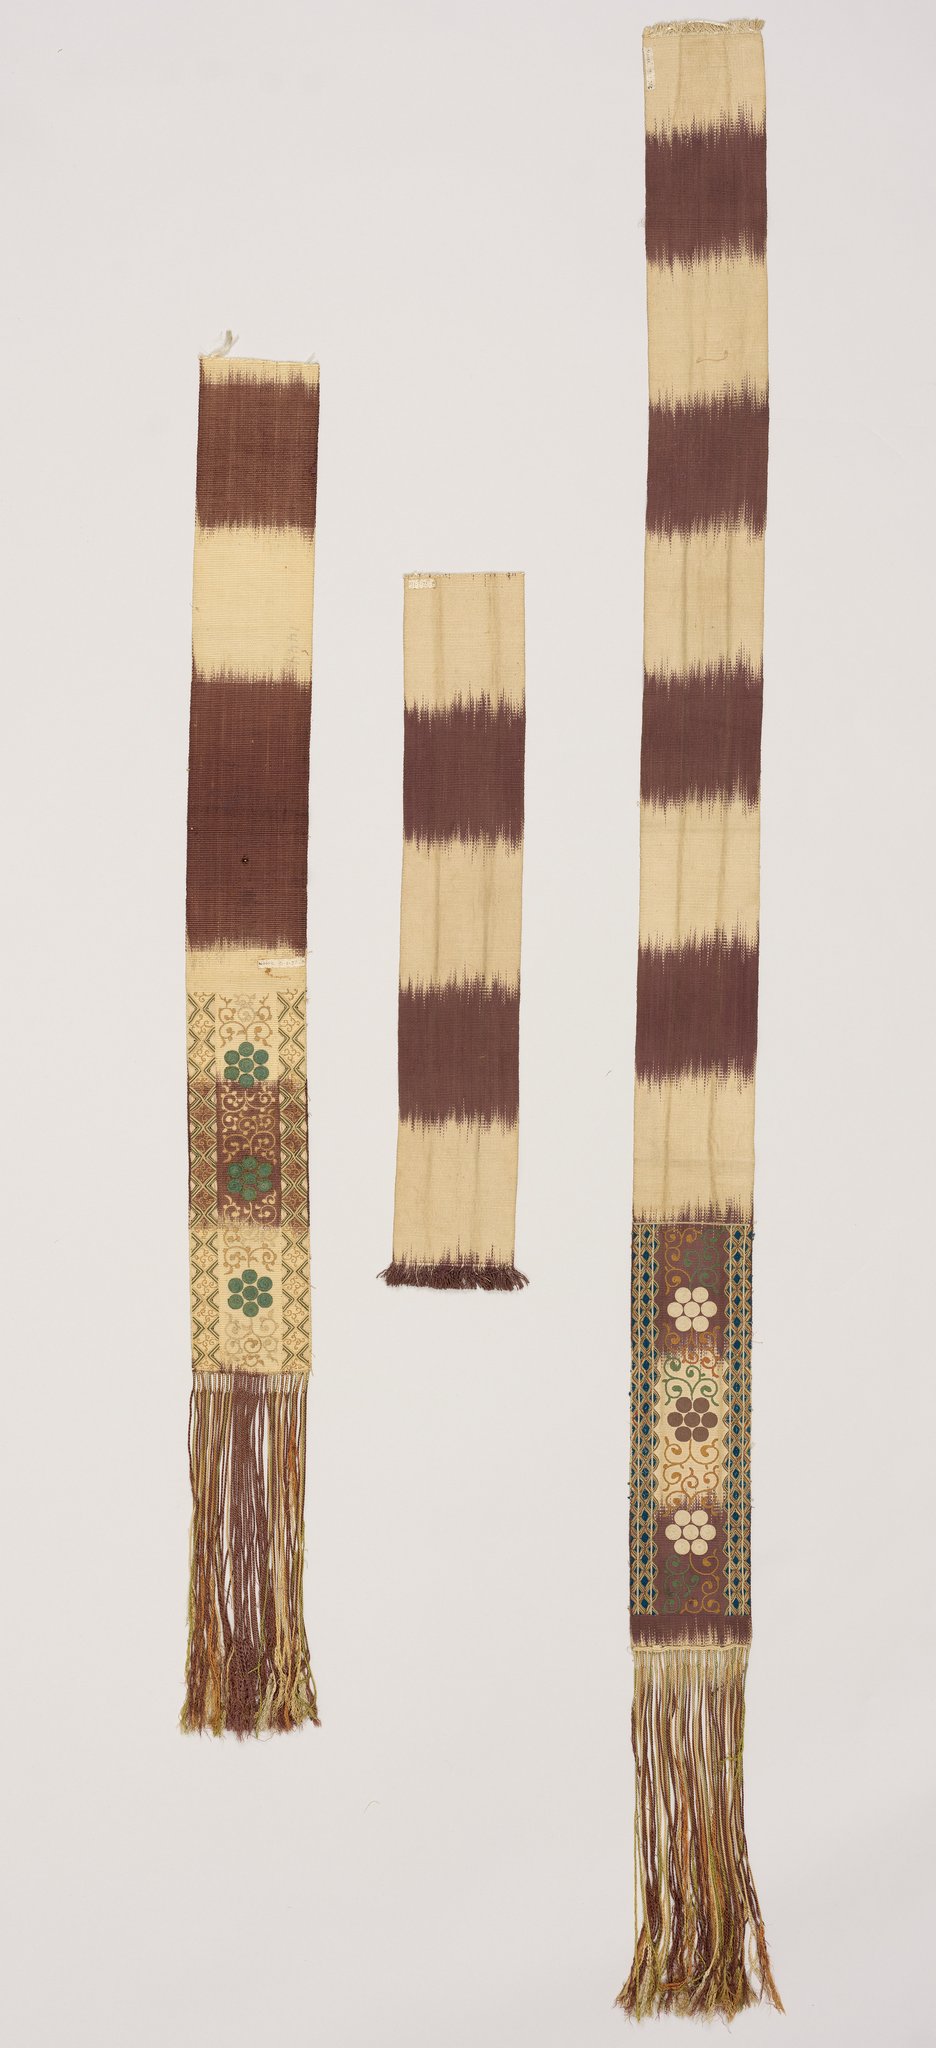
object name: sash section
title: Three Sections of Sash (Hirao)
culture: japanese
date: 1867-1900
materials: silk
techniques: embroidery